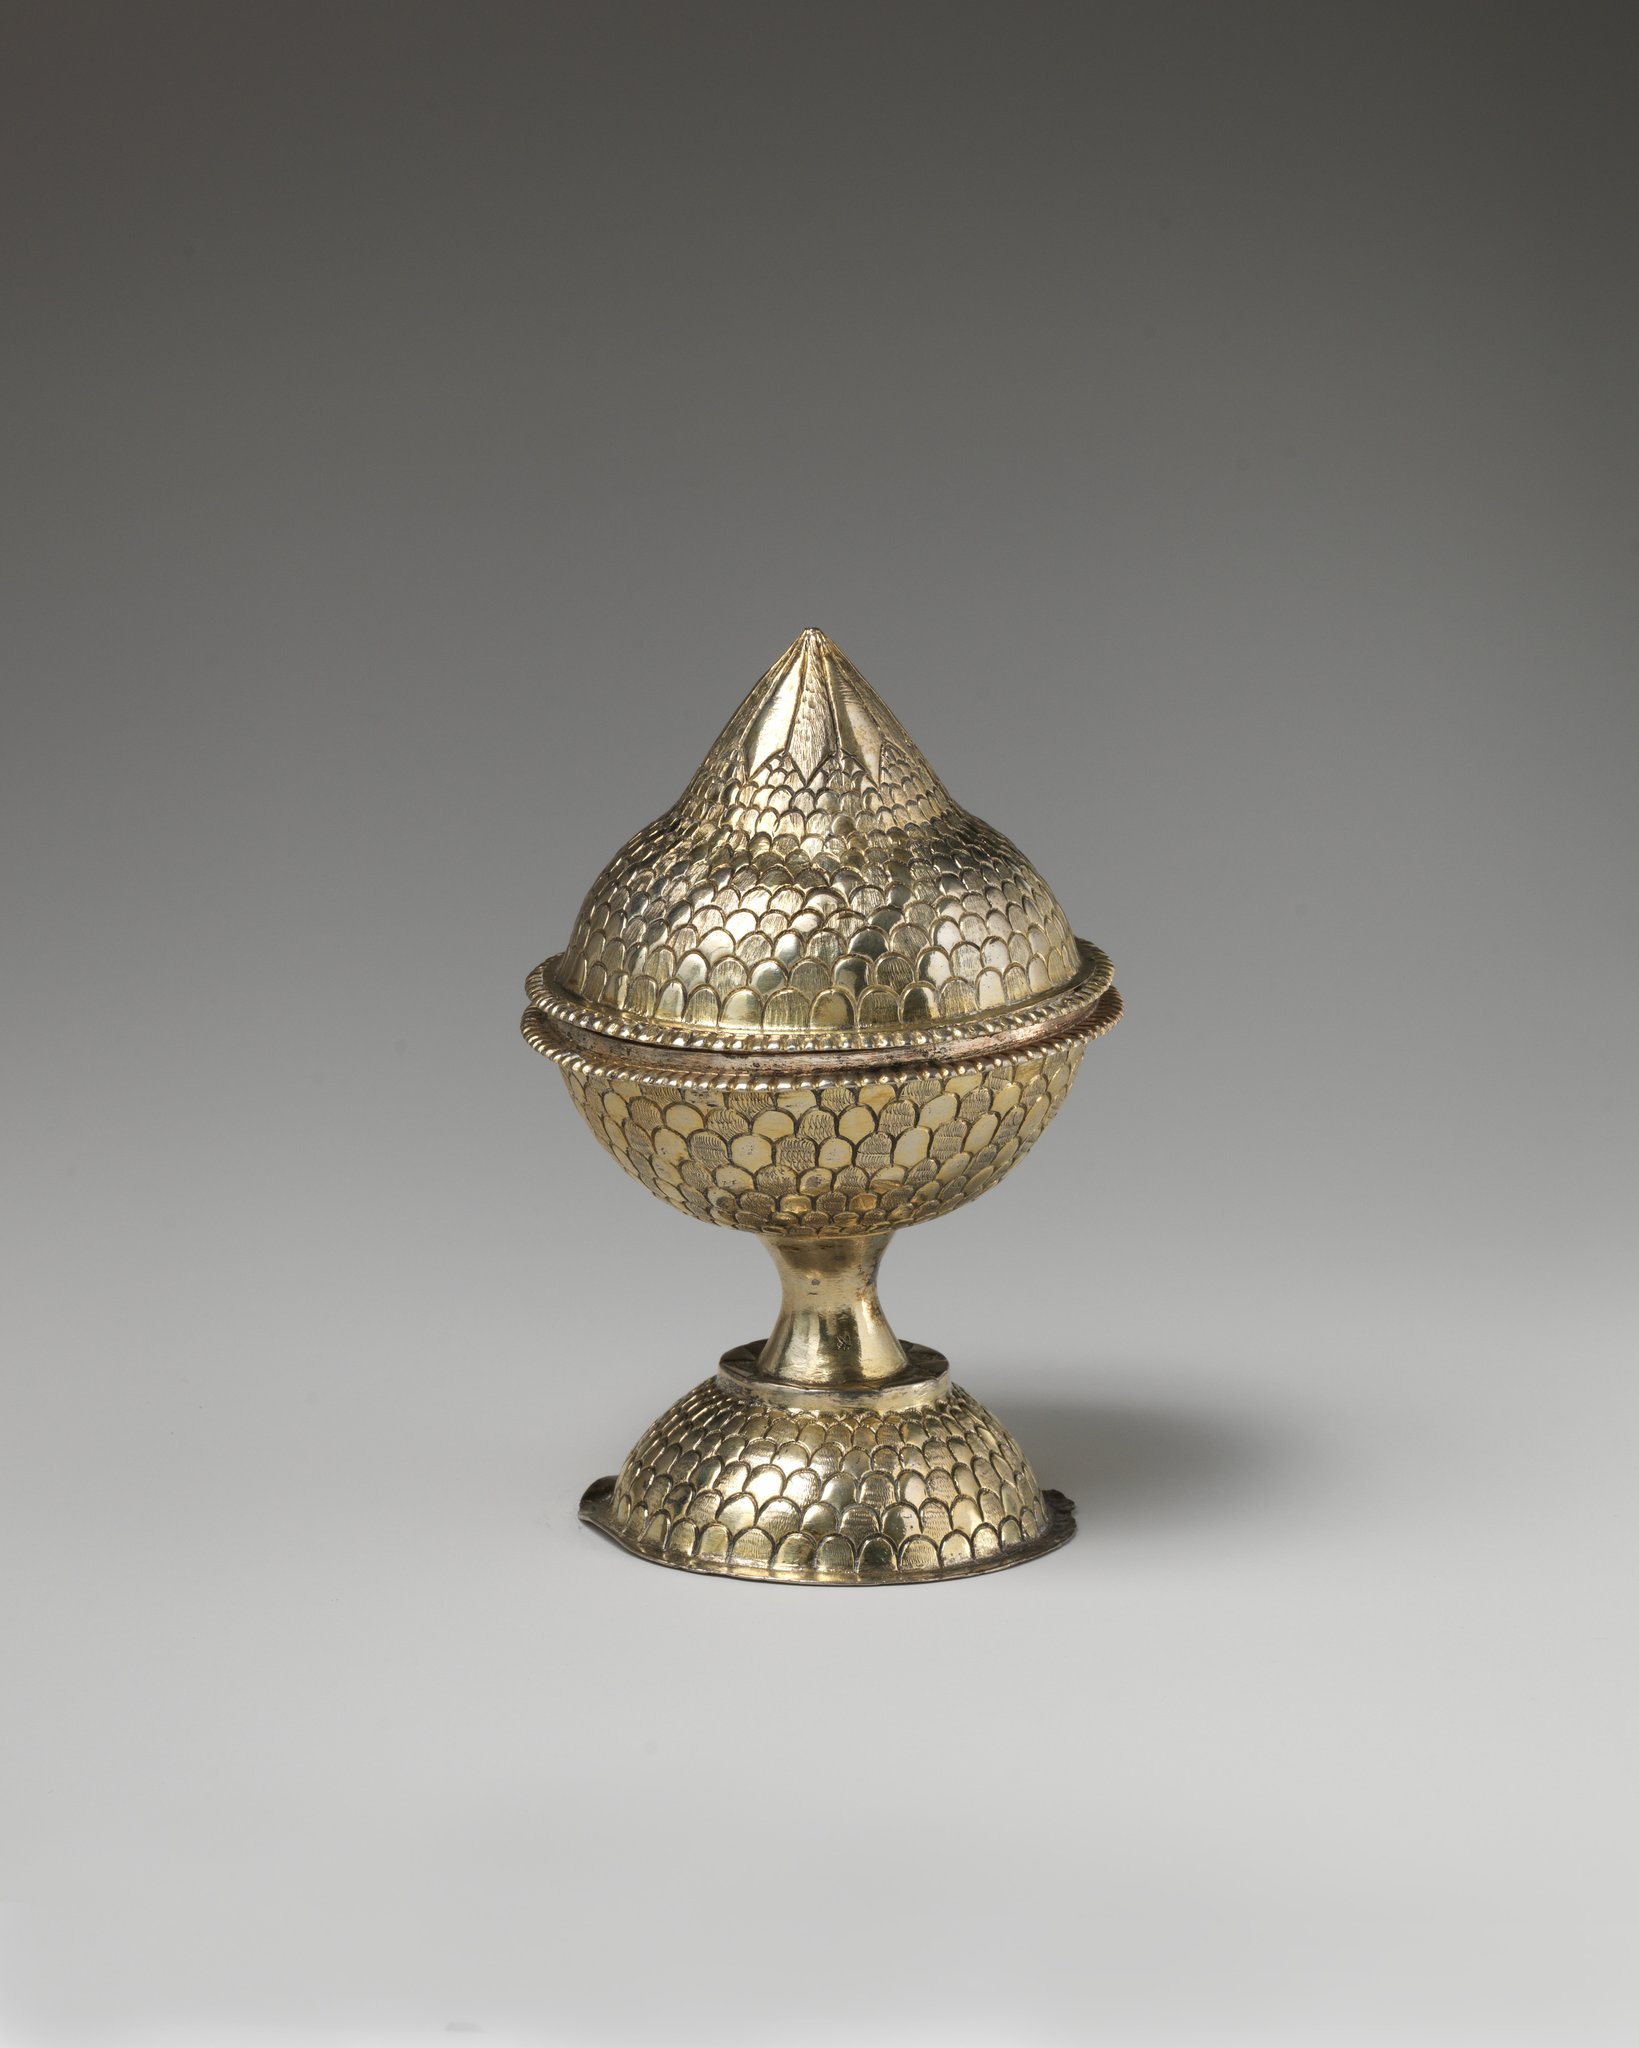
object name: salt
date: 1501-1550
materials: silver gilt